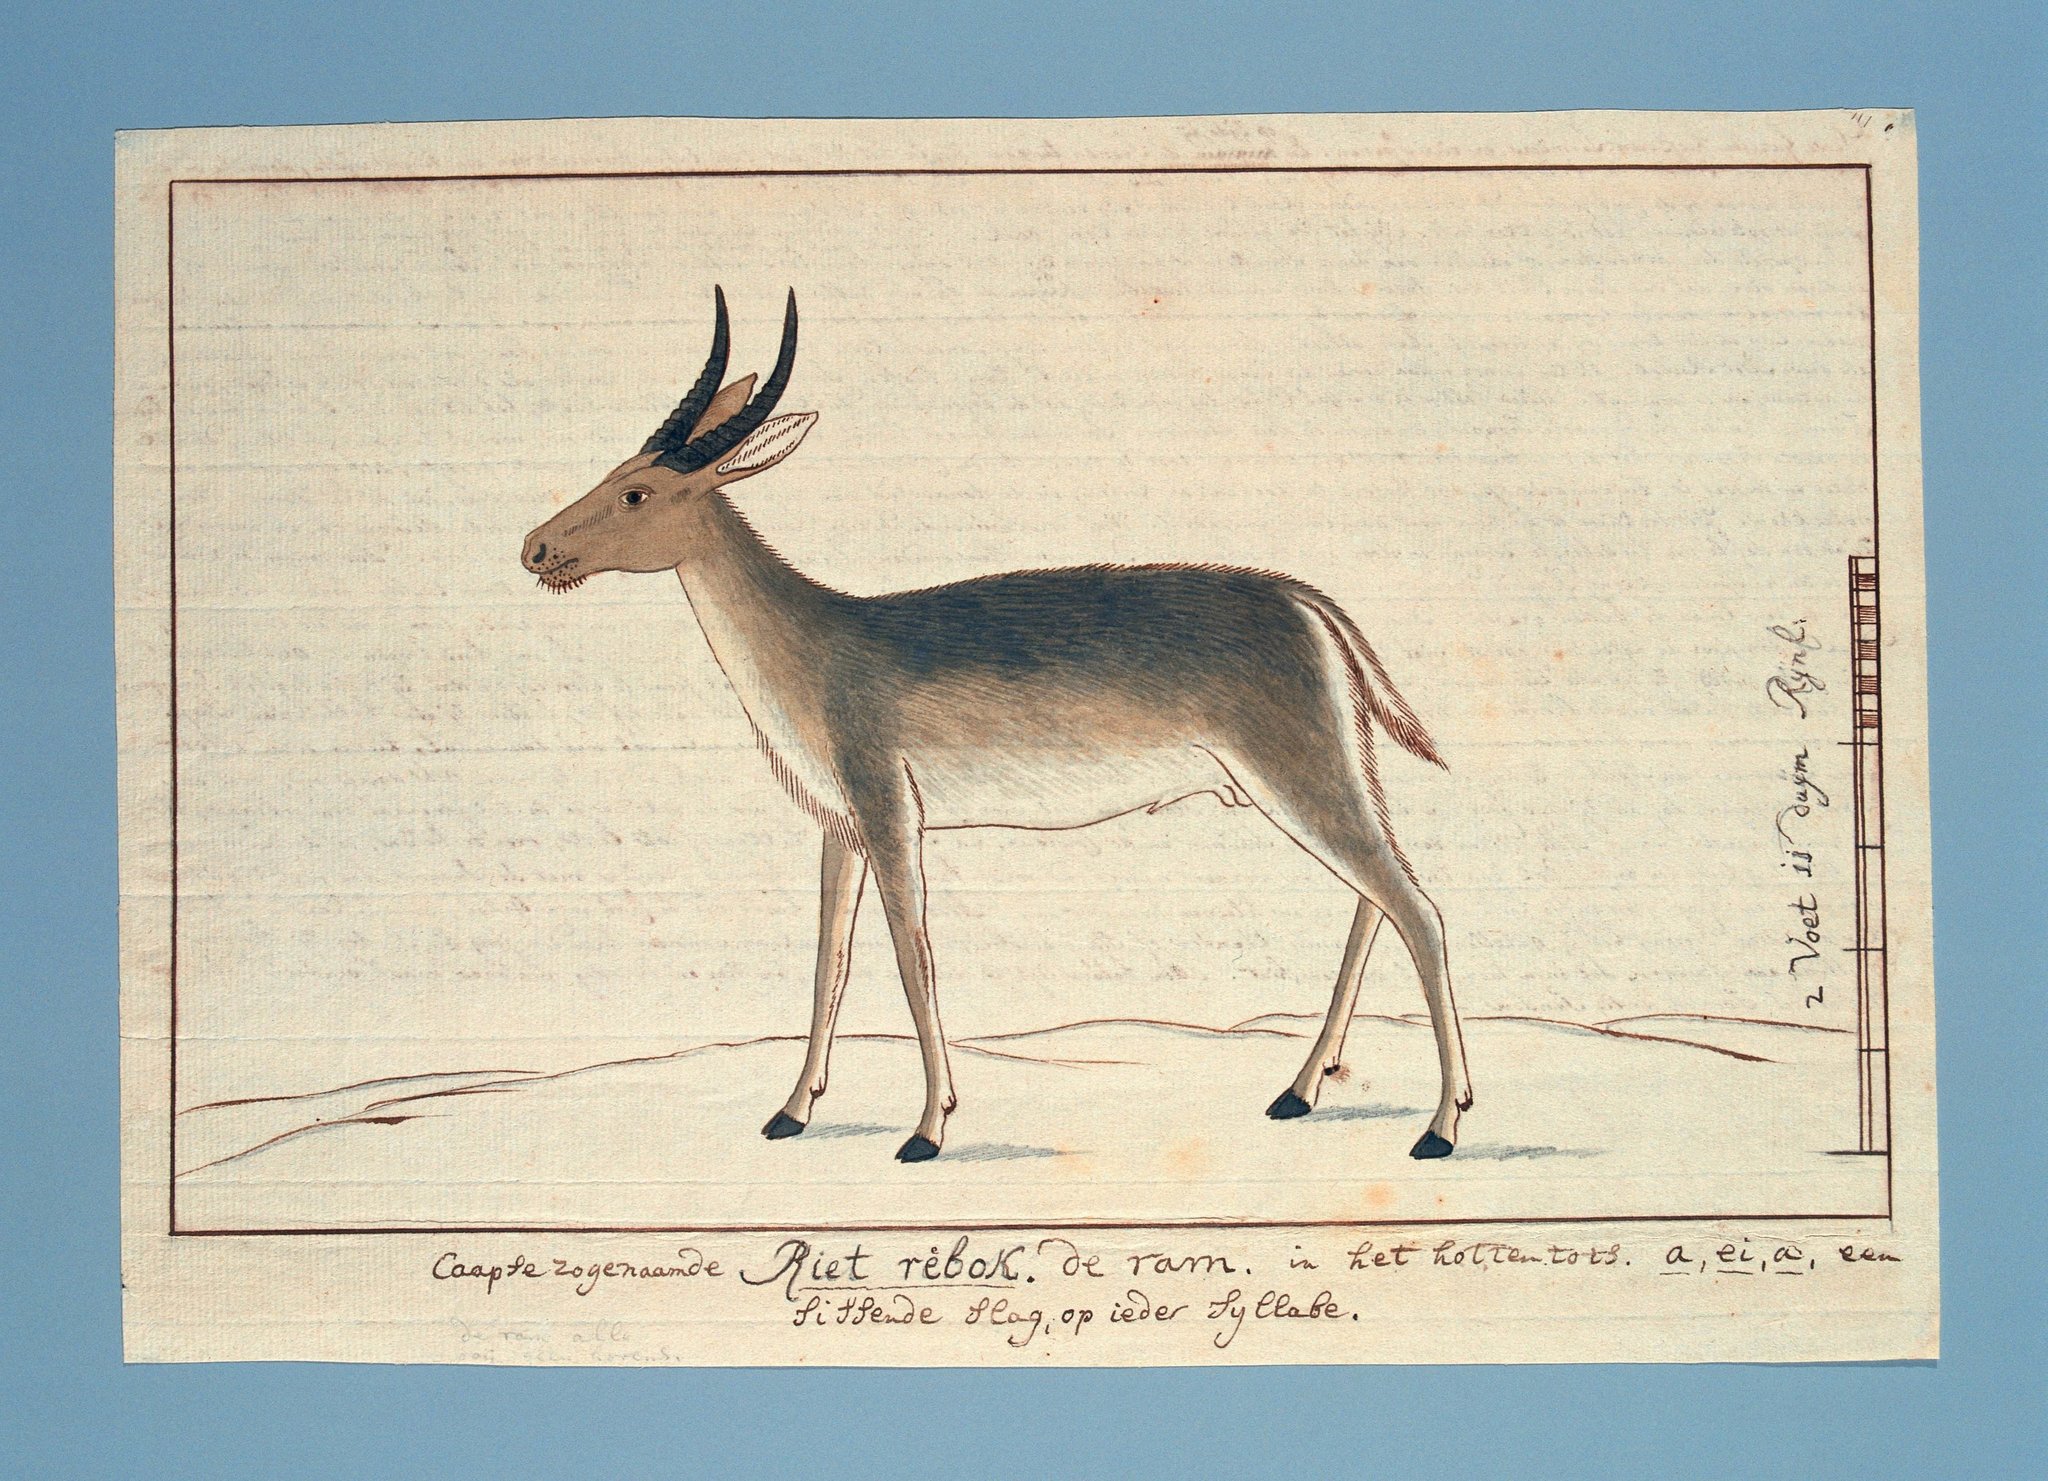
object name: album leaf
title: Redunca arundinum (Southern reedbuck; male)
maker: robert jacob gordon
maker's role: draughtsman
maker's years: 1743-1795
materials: chalk, ink, paper, pencil, watercolor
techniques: brush, pen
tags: animals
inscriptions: annotation: ‘Caapse zogenaamde Riet Rebok. [onderstreept, e met º erboven]. de ram. [...]; schaalverdeling met: 2 Voet ii duijm Rijnl. [over potlood]’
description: Rietreebok of rode rietbok (Redunca arundinum), voorheen redunca fulvorufula; met schaalverdeling in Rijnlandse maat.